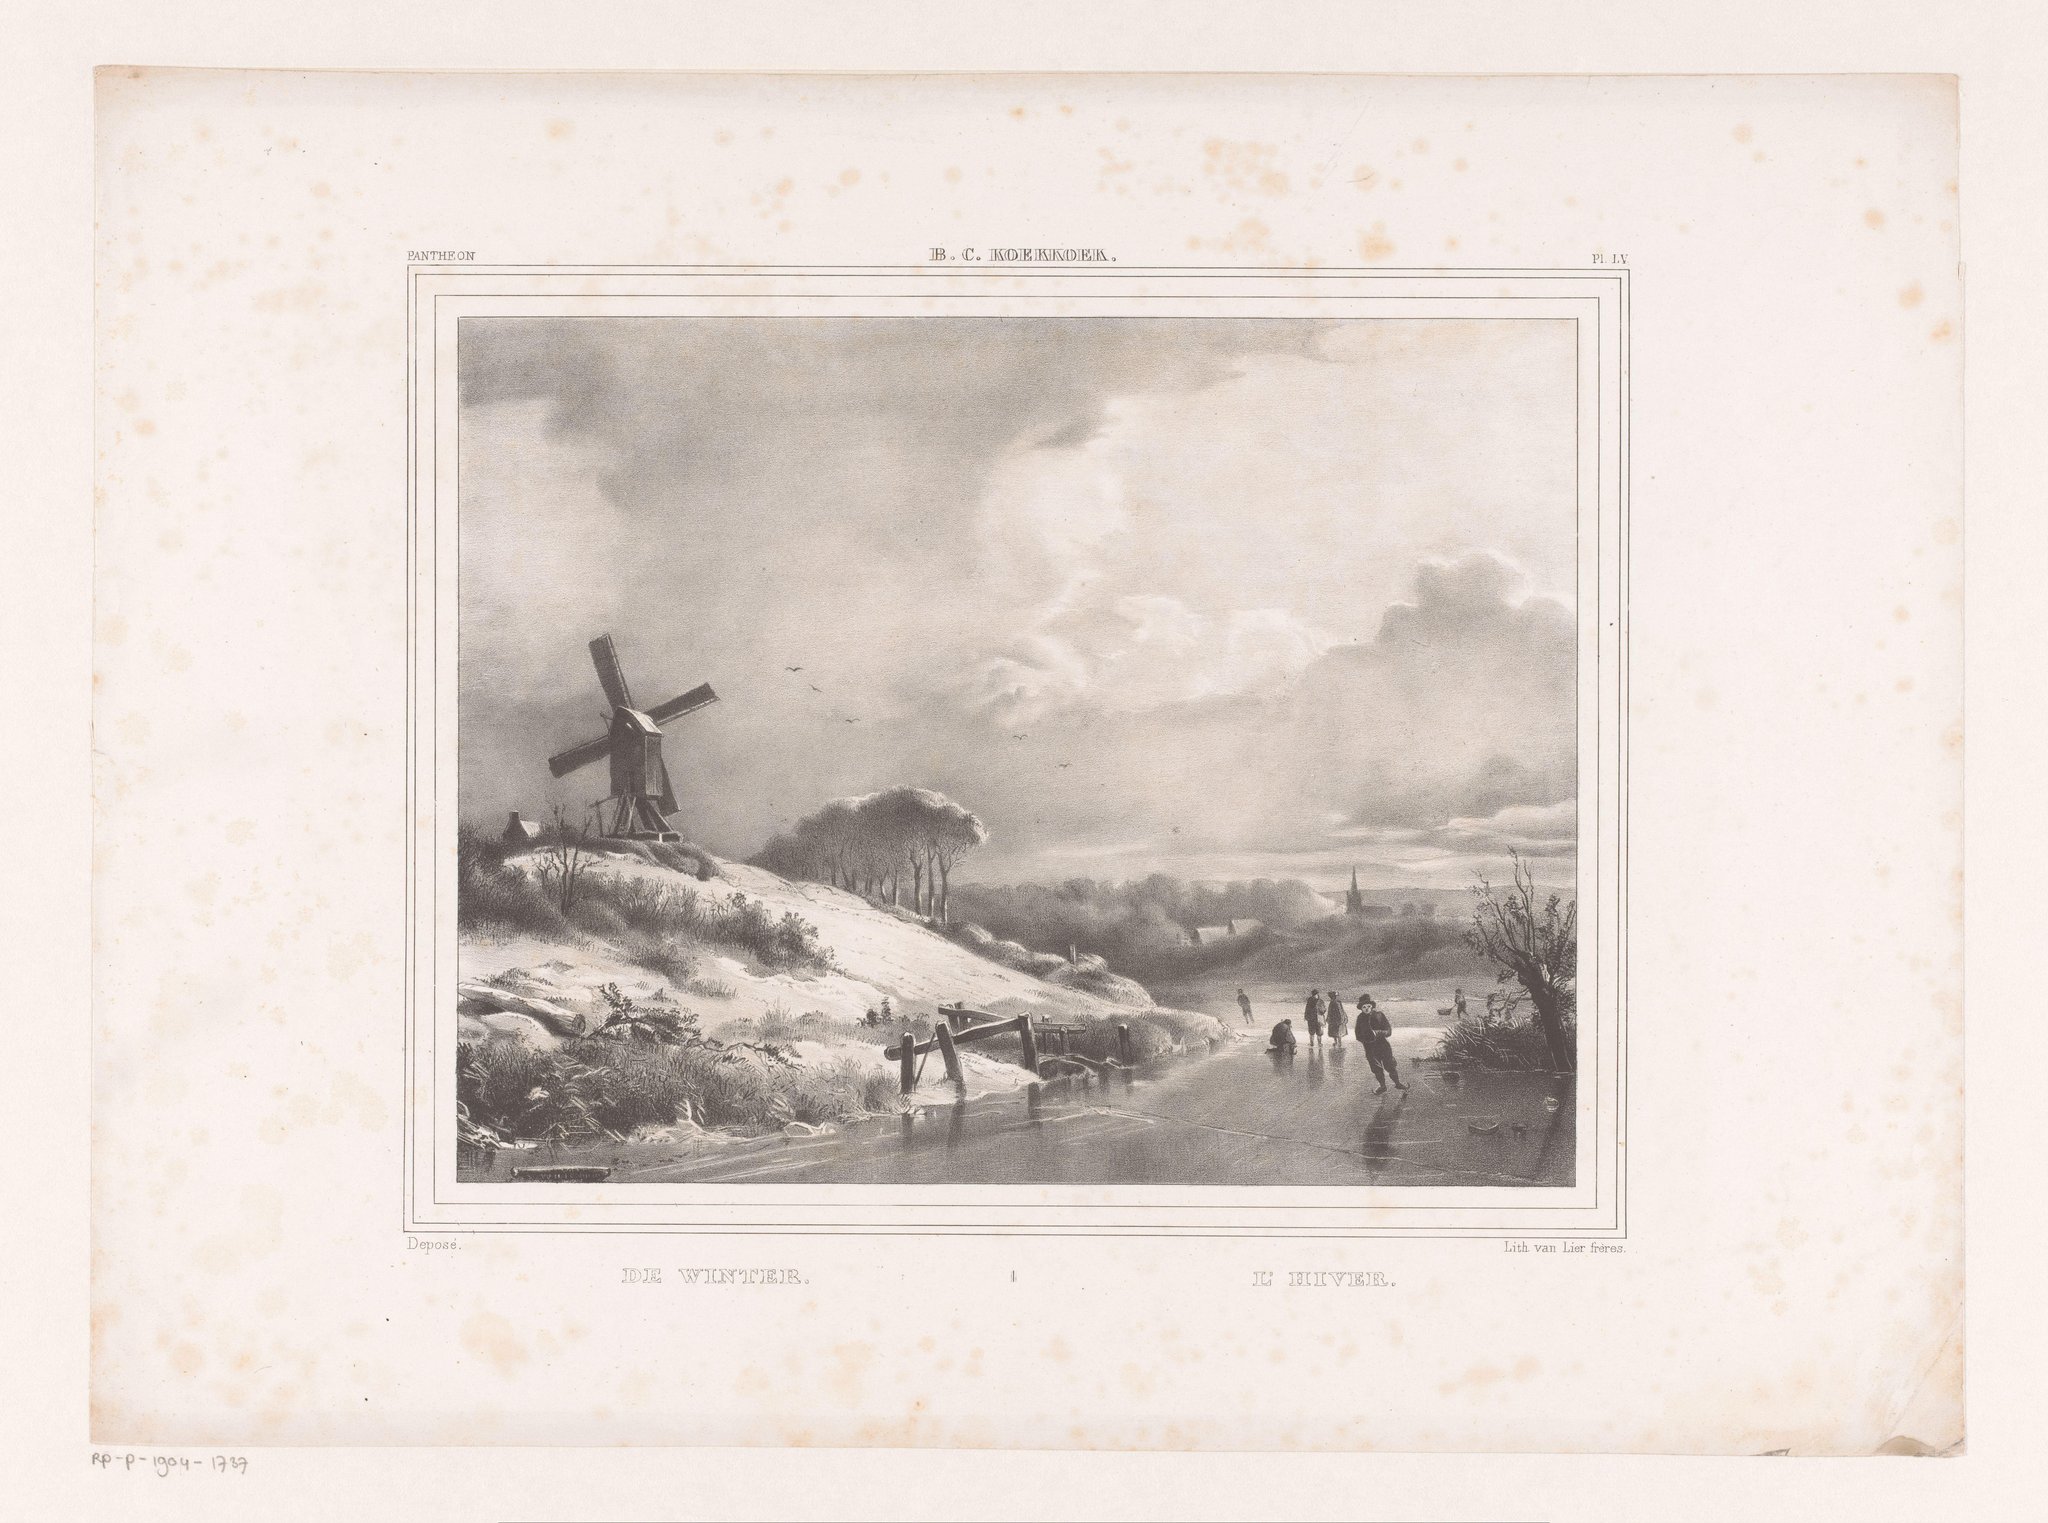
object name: print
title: Winterlandschap met schaatsers op een rivier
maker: barend cornelis koekkoek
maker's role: draughtsman, painter, print maker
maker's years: 1803-1862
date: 1837-1843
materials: paper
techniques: lithograph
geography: the hague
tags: ice ~ freezing weather, windmill in landscape, skates (winter sports), river (+ landscape with figures, staffage)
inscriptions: collector's mark: Lugt 2228, : ‘Deposé’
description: Deze prent maakte mogelijk deel uit van: Pantheon of de tempel der onsterfelijkheid van Nederlandse kunstschilders. Uitgegeven door Gebroeders Van Lier in Amsterdam tussen 1837 en (in ieder geval) 1843.